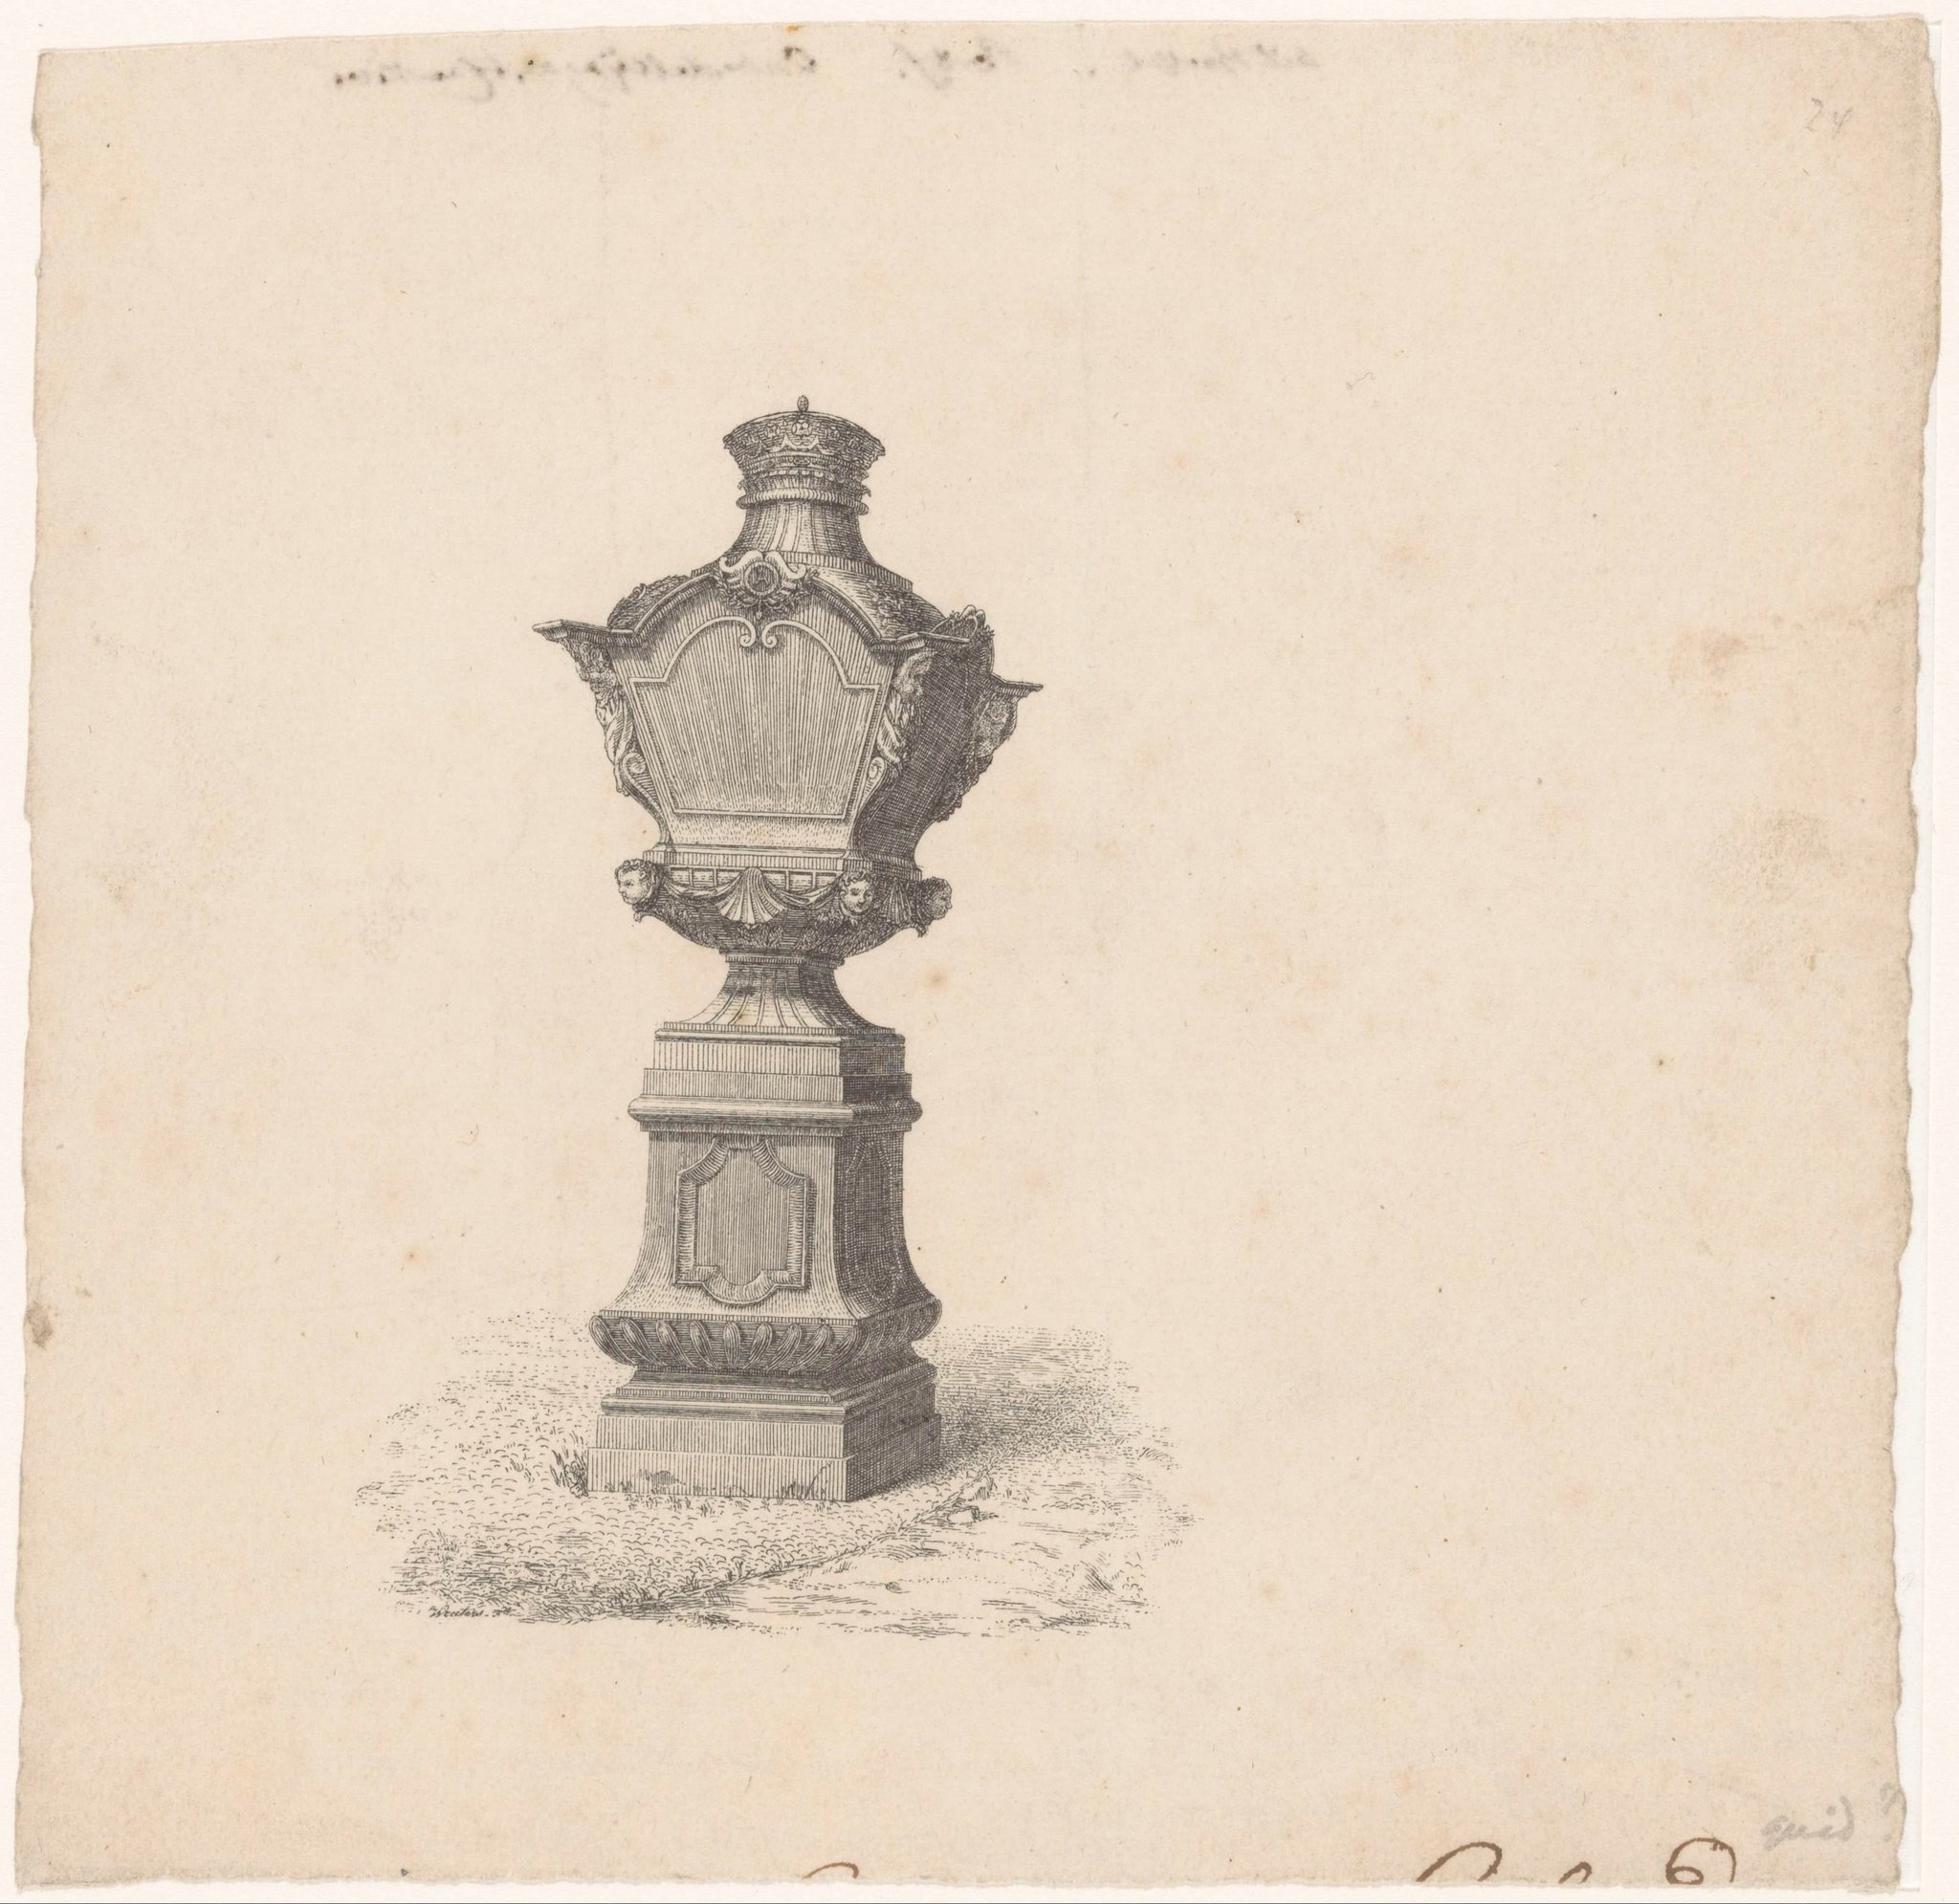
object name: print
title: Vaas op voetstuk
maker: Anonymous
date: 1700-1850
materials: paper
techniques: etching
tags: vase ~ ornament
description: Een bekroonde vaas met maskers en schelpmotieven op een voetstuk. Doorgedrukt en geschreven tekst op achterzijde.